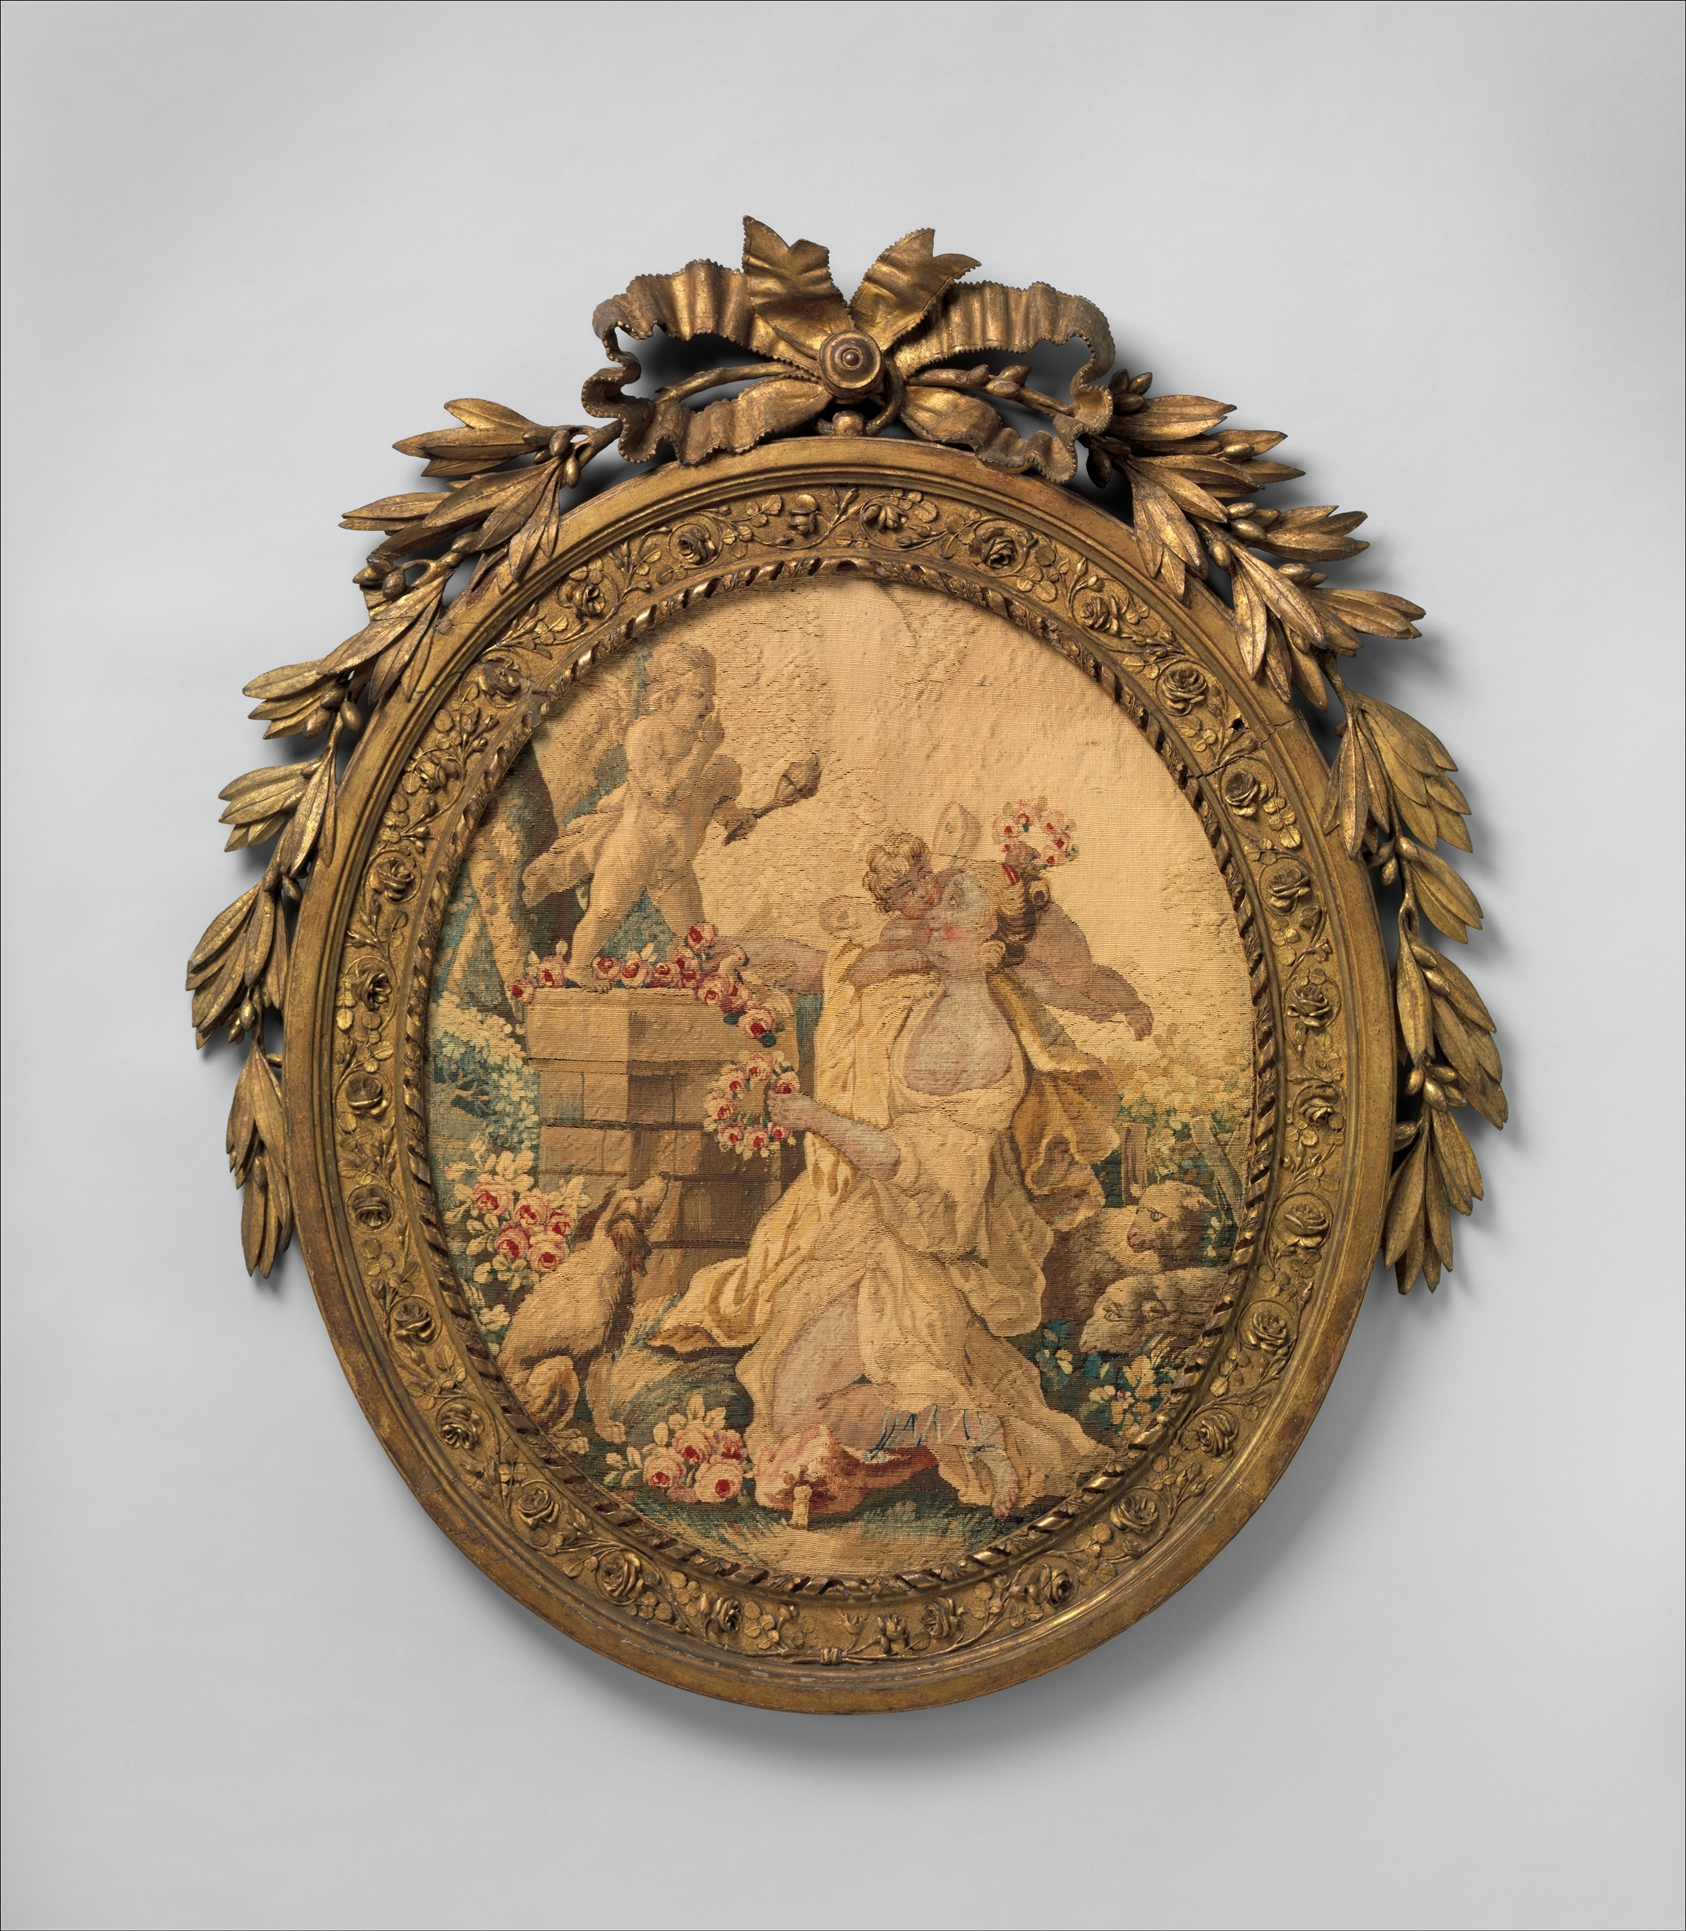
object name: tapestry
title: The Worship of Cupid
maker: jean-baptiste huet i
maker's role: designer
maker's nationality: french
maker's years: 1745-1811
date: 1775-1790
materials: silk, wool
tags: women,cupid,dogs,sheep